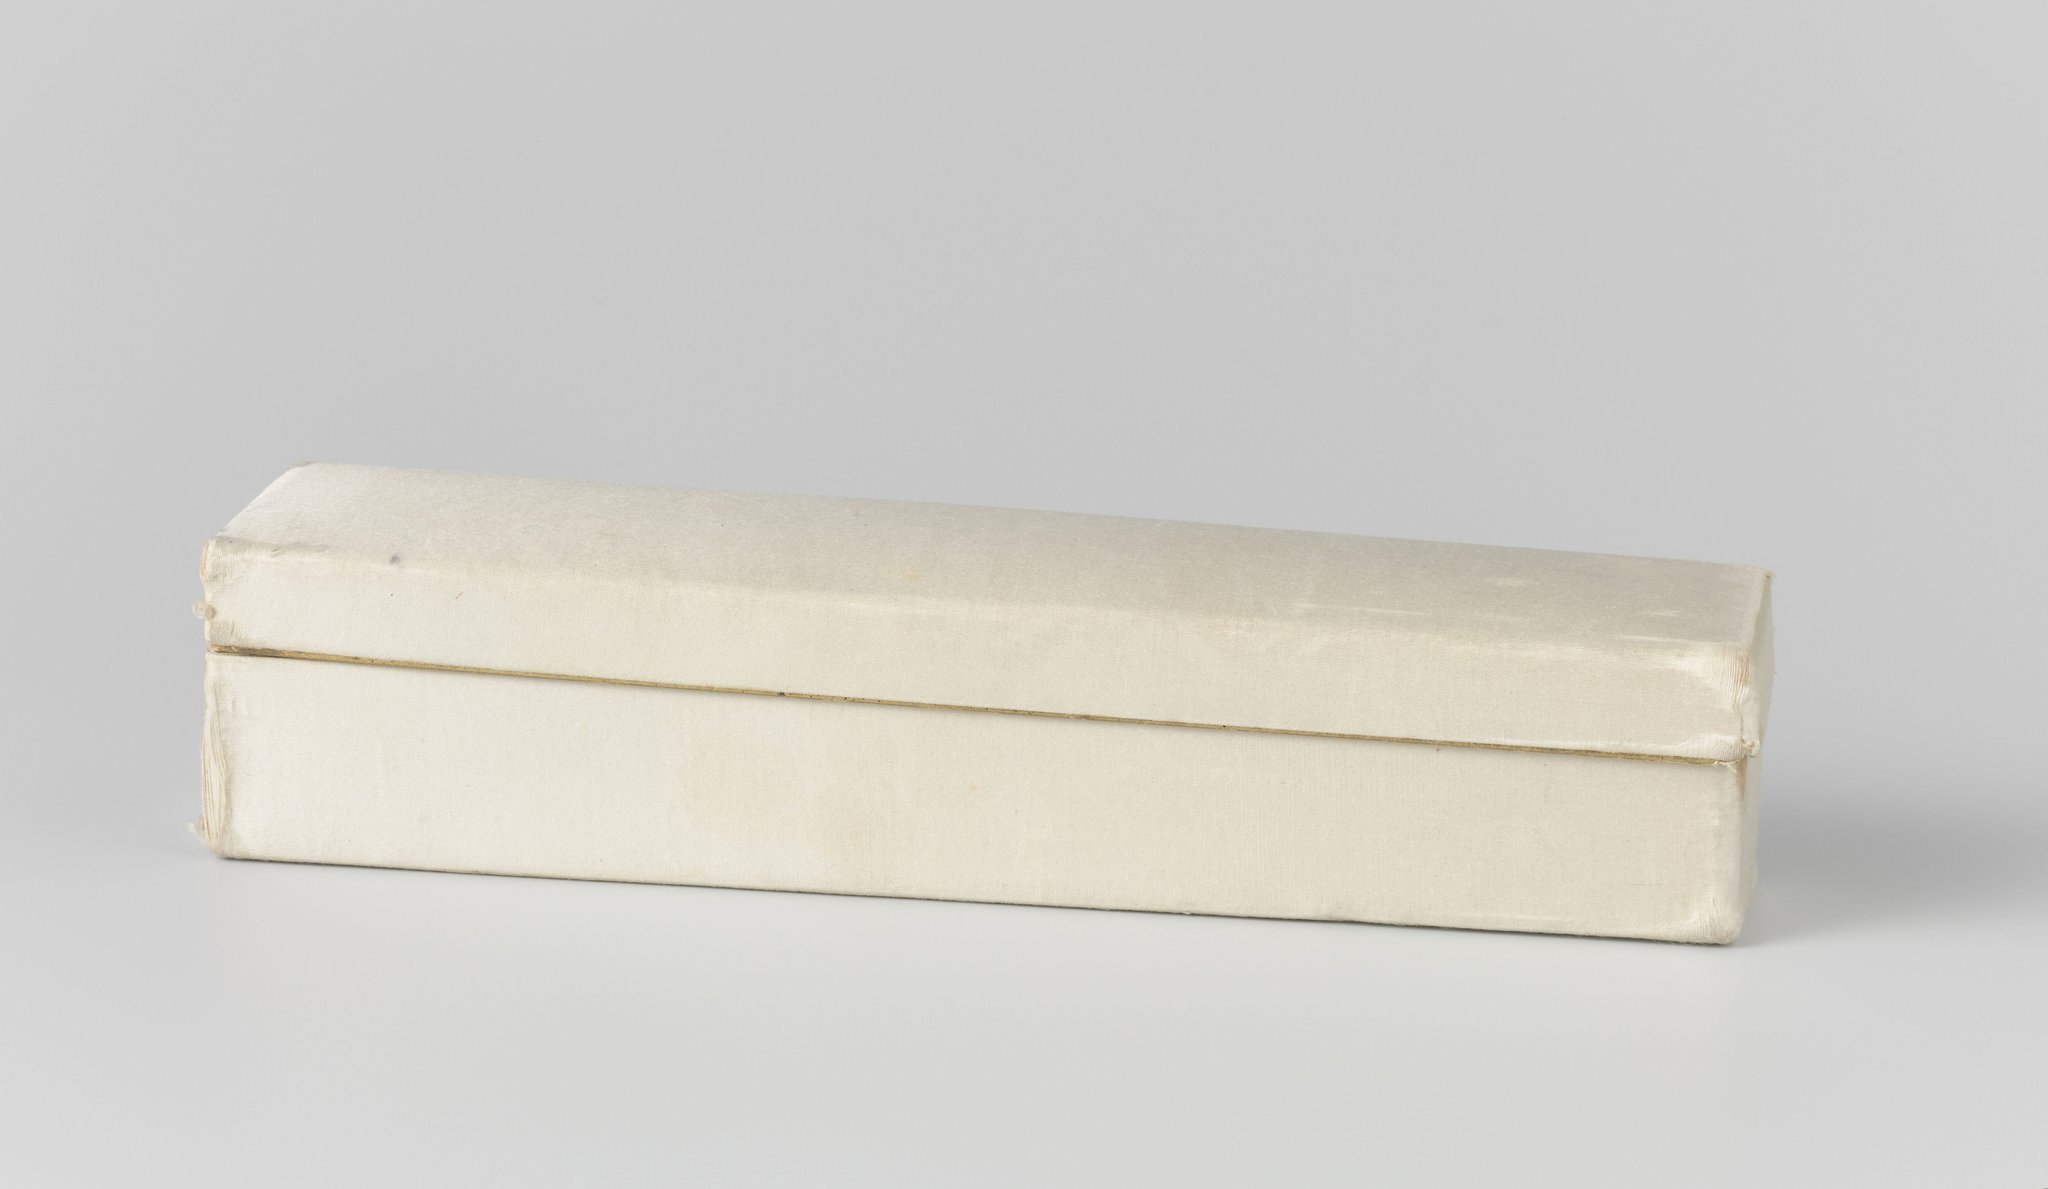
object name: waaierdoos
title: Taps toelopende waaierdoos van karton, geheel bekleed met wit satijn en op de randen voorzien van goudverf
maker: Anonymous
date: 1910-1920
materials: cardboard, paint, textile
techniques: painting, weave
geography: europe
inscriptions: address: ‘H.N. van Santen/ Kais. u. Kgl. Hoflieferant/ Frankfurt a. Main’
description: Taps toelopende waaierdoos van karton, geheel bekleed met wit satijn en op de randen voorzien van goudverf. Papieren adres in de deksel geplakt: H.N. van Santen/ Kais. u. Kgl. Hoflieferant/ Frankfurt a. M.